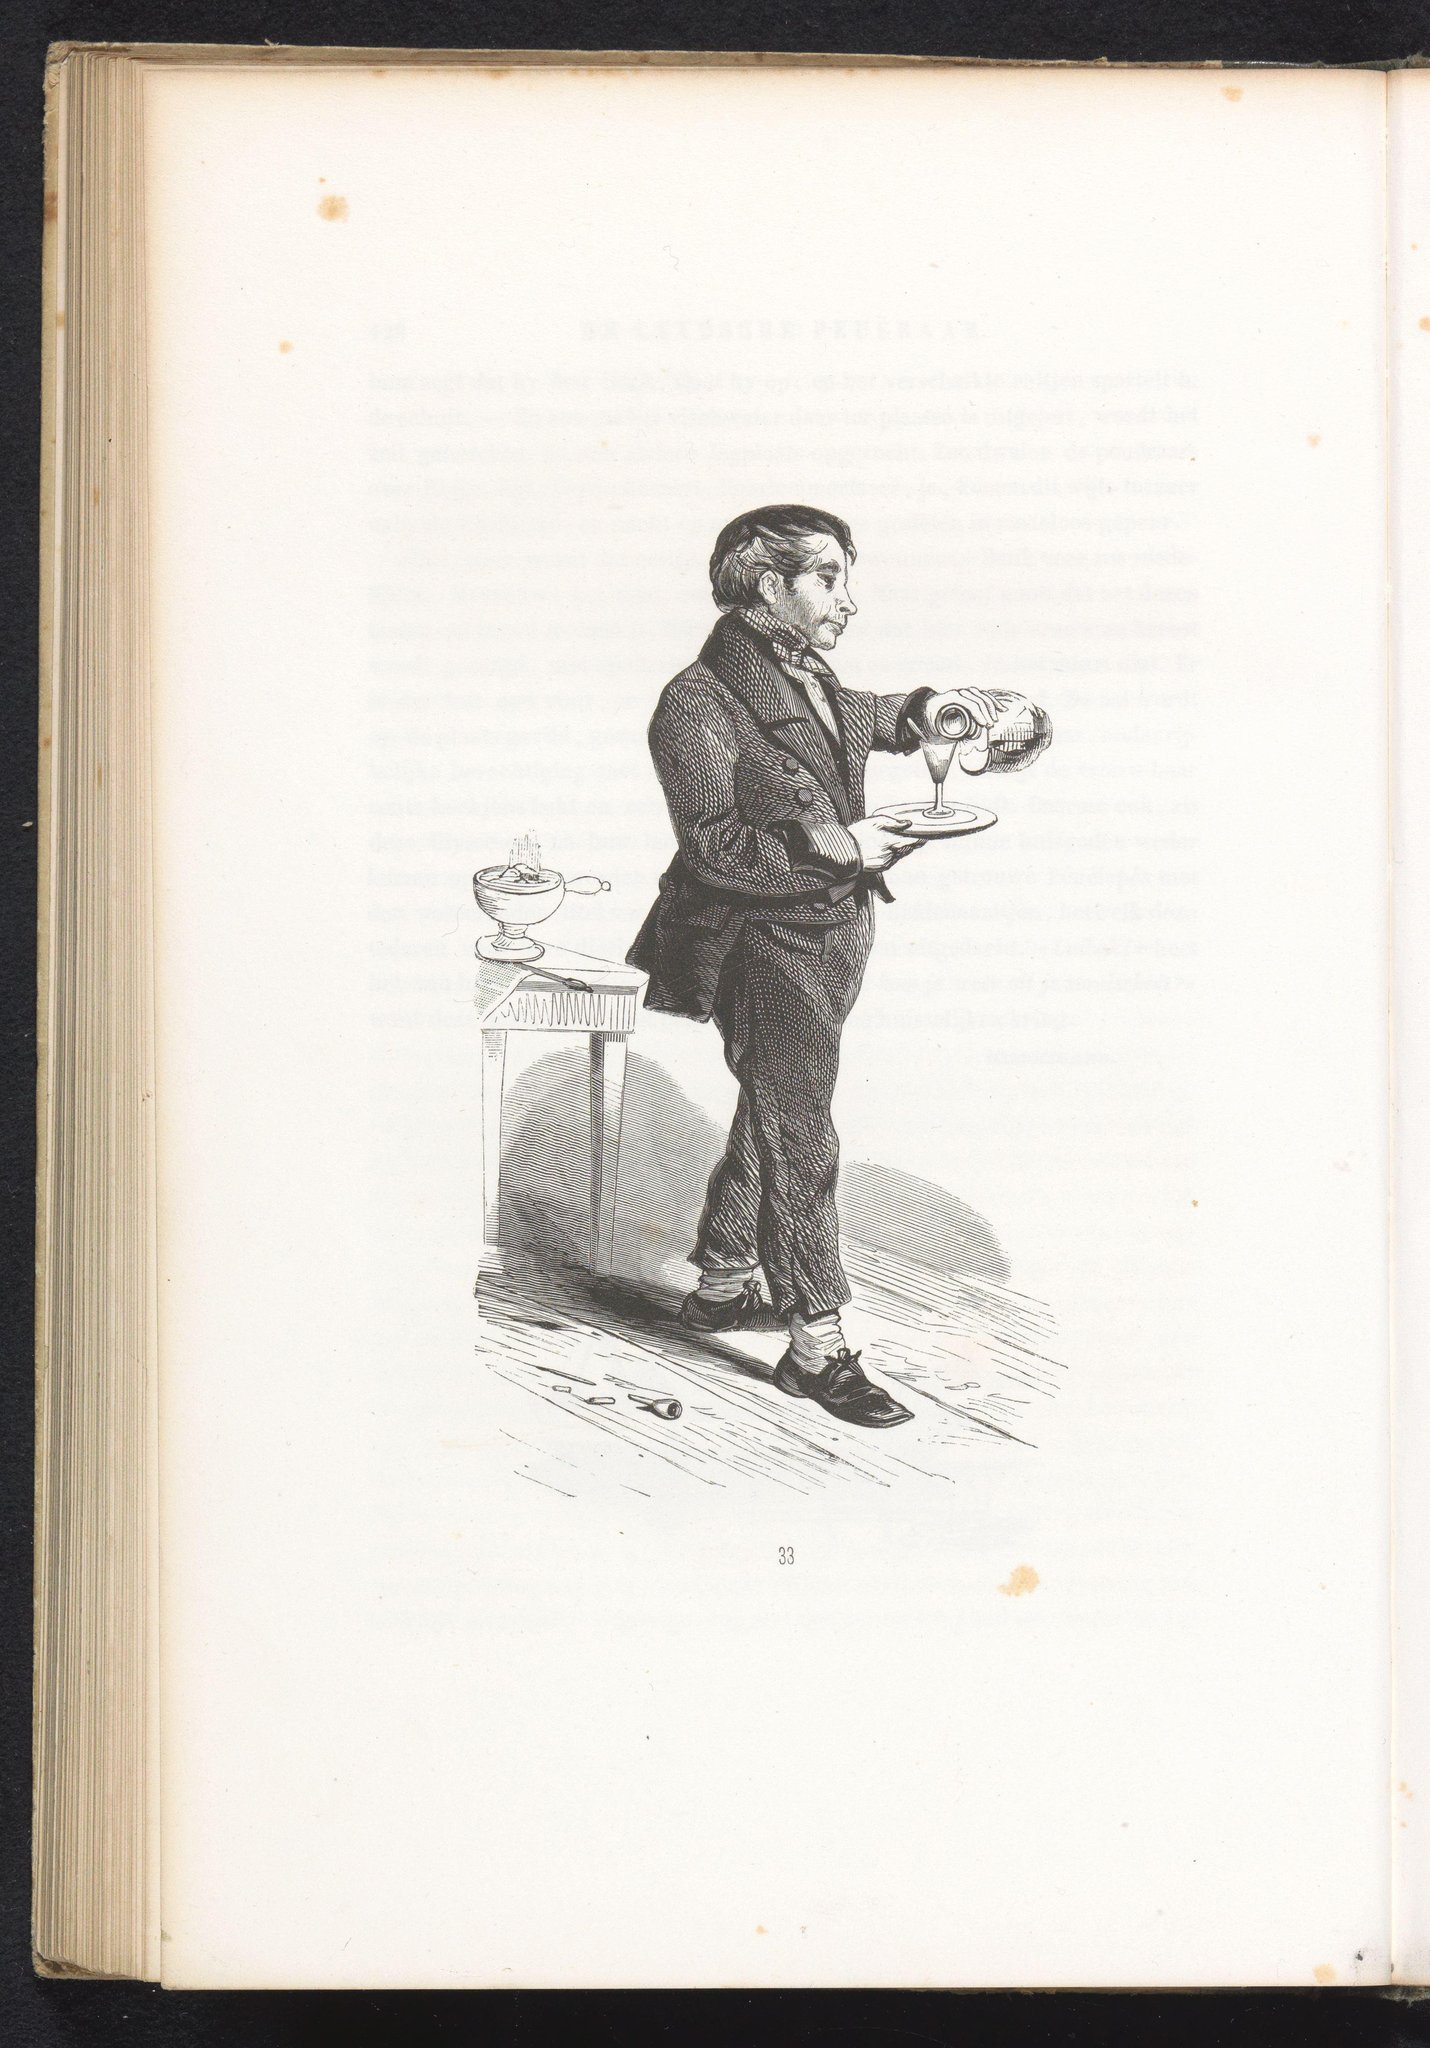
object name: print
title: De koffiehuisjongen, 1840-1841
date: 1841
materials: paper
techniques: letterpress printing, engraving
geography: netherlands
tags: professional clothes, inn, coffee-house, public house, etc. (+ waiter, waitress, etc.), netherlands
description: Een bediende in een koffiehuis. Staande jongen schenkt een glas in. Genummerd: 33. Illustratie in het boek 'De Nederlanden: karakterschetsen, kleederdrachten, houding en voorkomen van verschillende standen', een boek met karakterschetsen, beroepen en klederdrachten van Nederlandse volkstypen uit 1841.